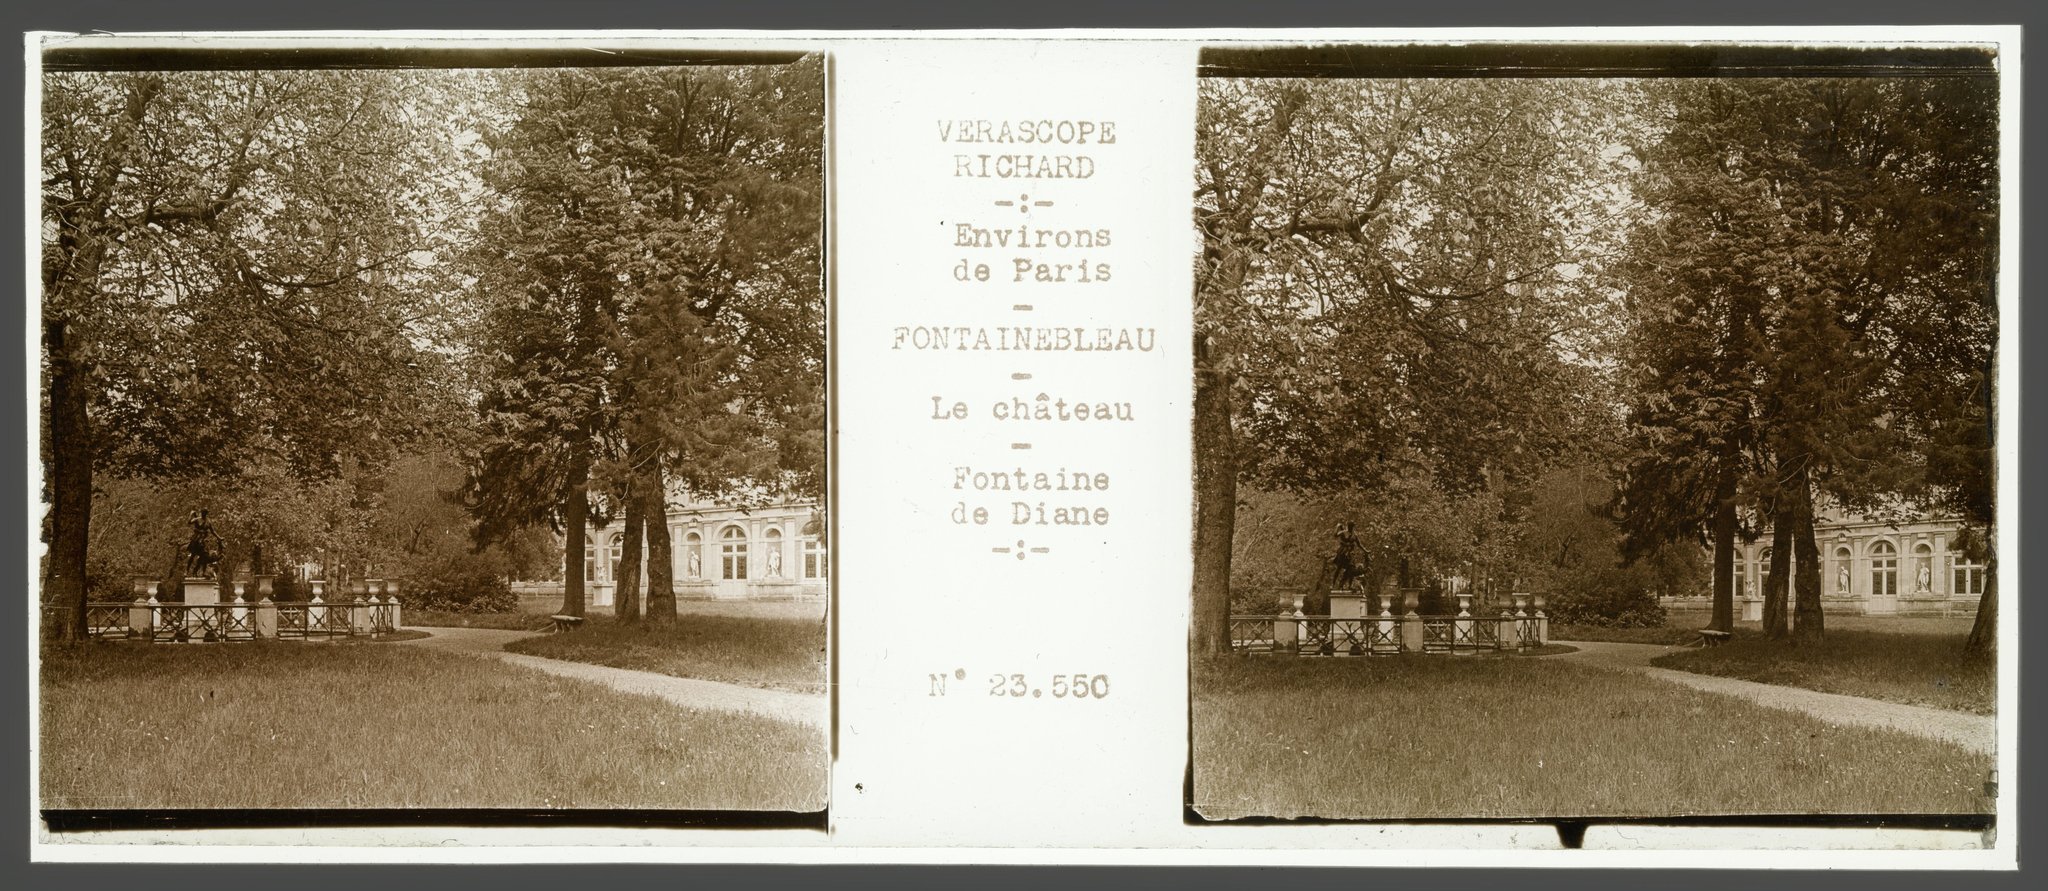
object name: stereoscopic photograph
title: Environs de Paris - Fontainebleau - Le château - Fontaine de Diane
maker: Anonymous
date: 1893-1920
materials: glass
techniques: gelatin silver transparency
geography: paris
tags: garden fountain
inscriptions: number: ‘No 23.550’